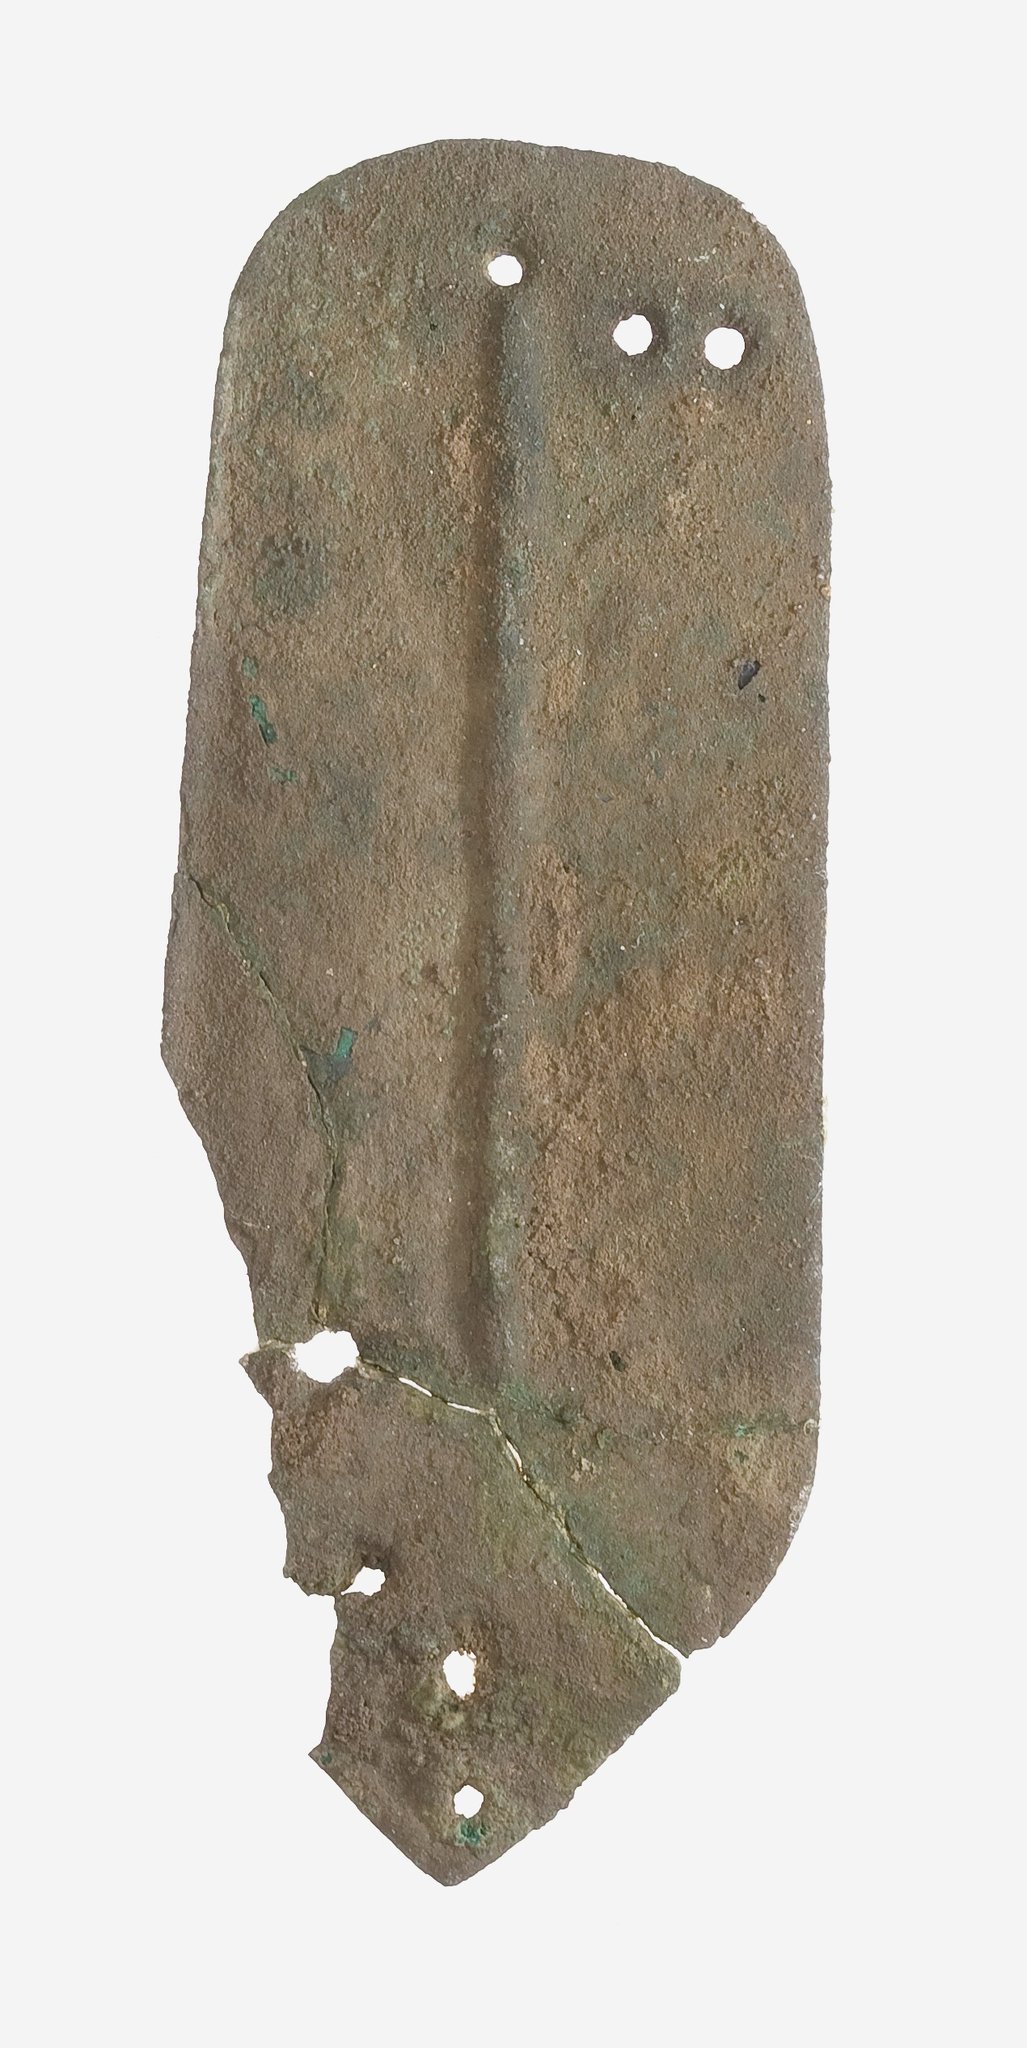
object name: armor scale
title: Scale from Armor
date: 1390-1352 BCE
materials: bronze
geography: egypt